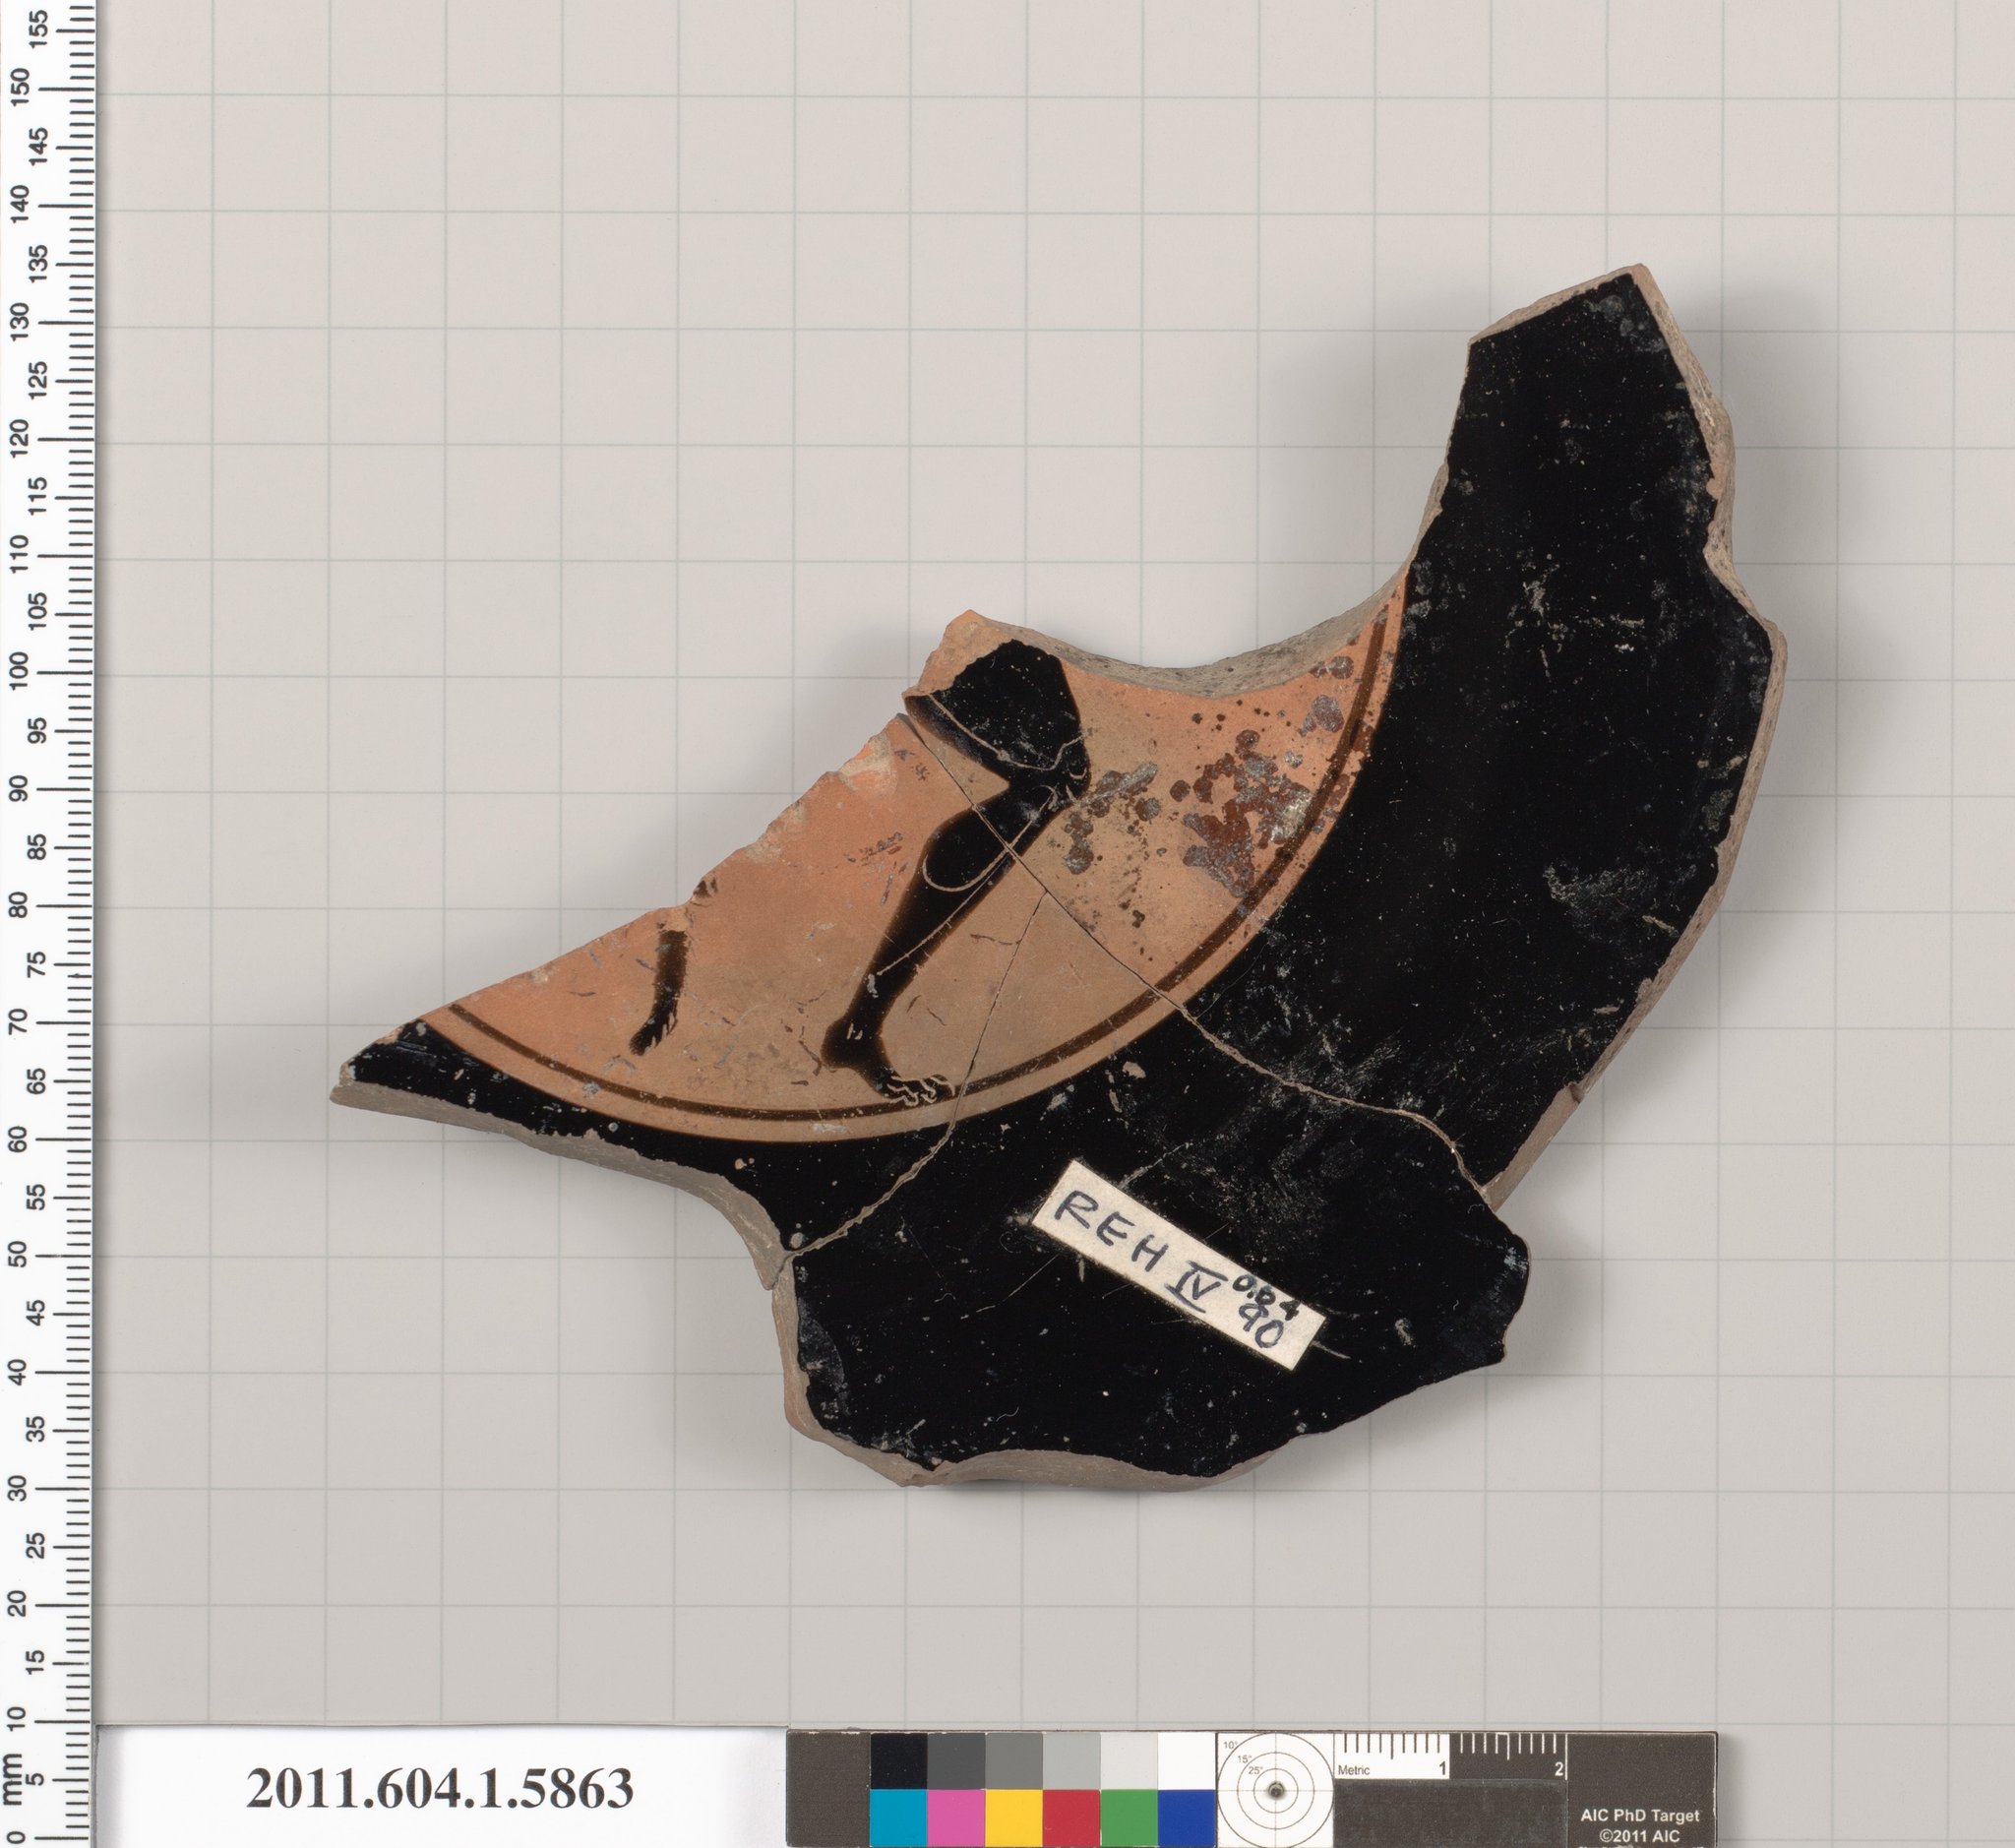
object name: kylix fragment, eye cup, bilingual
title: Terracotta fragment of a kylix (drinking cup)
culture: greek, attic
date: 433-567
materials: terracotta